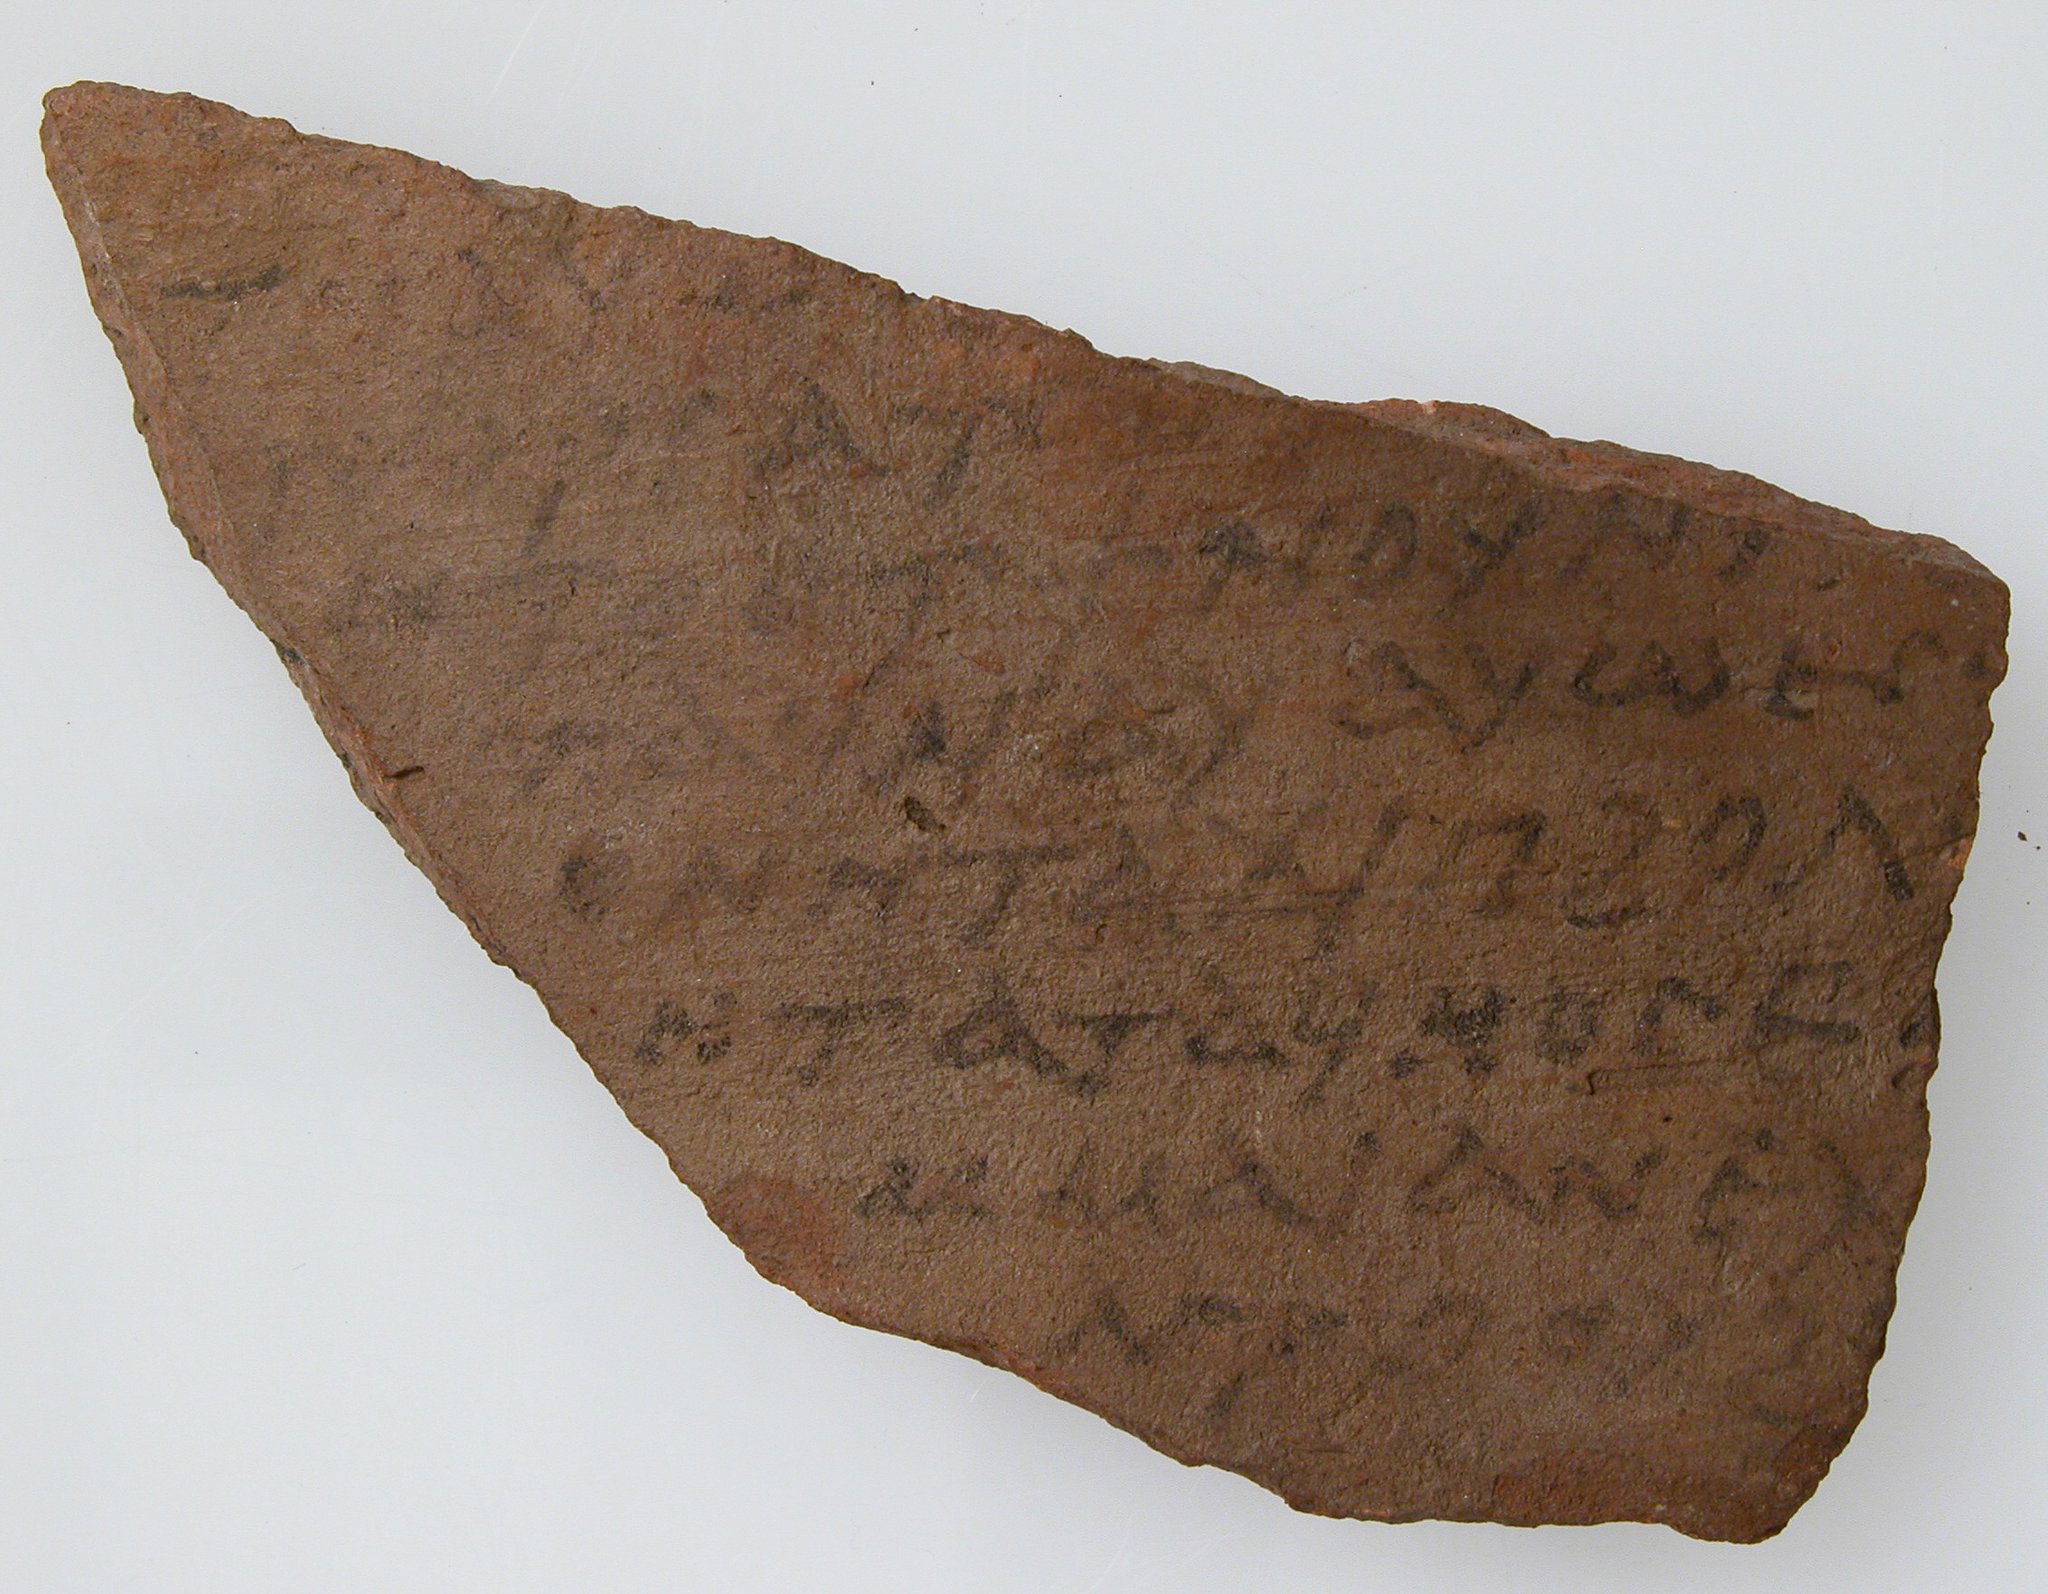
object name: ostrakon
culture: coptic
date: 601-700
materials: ink, pottery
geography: egypt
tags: coptic